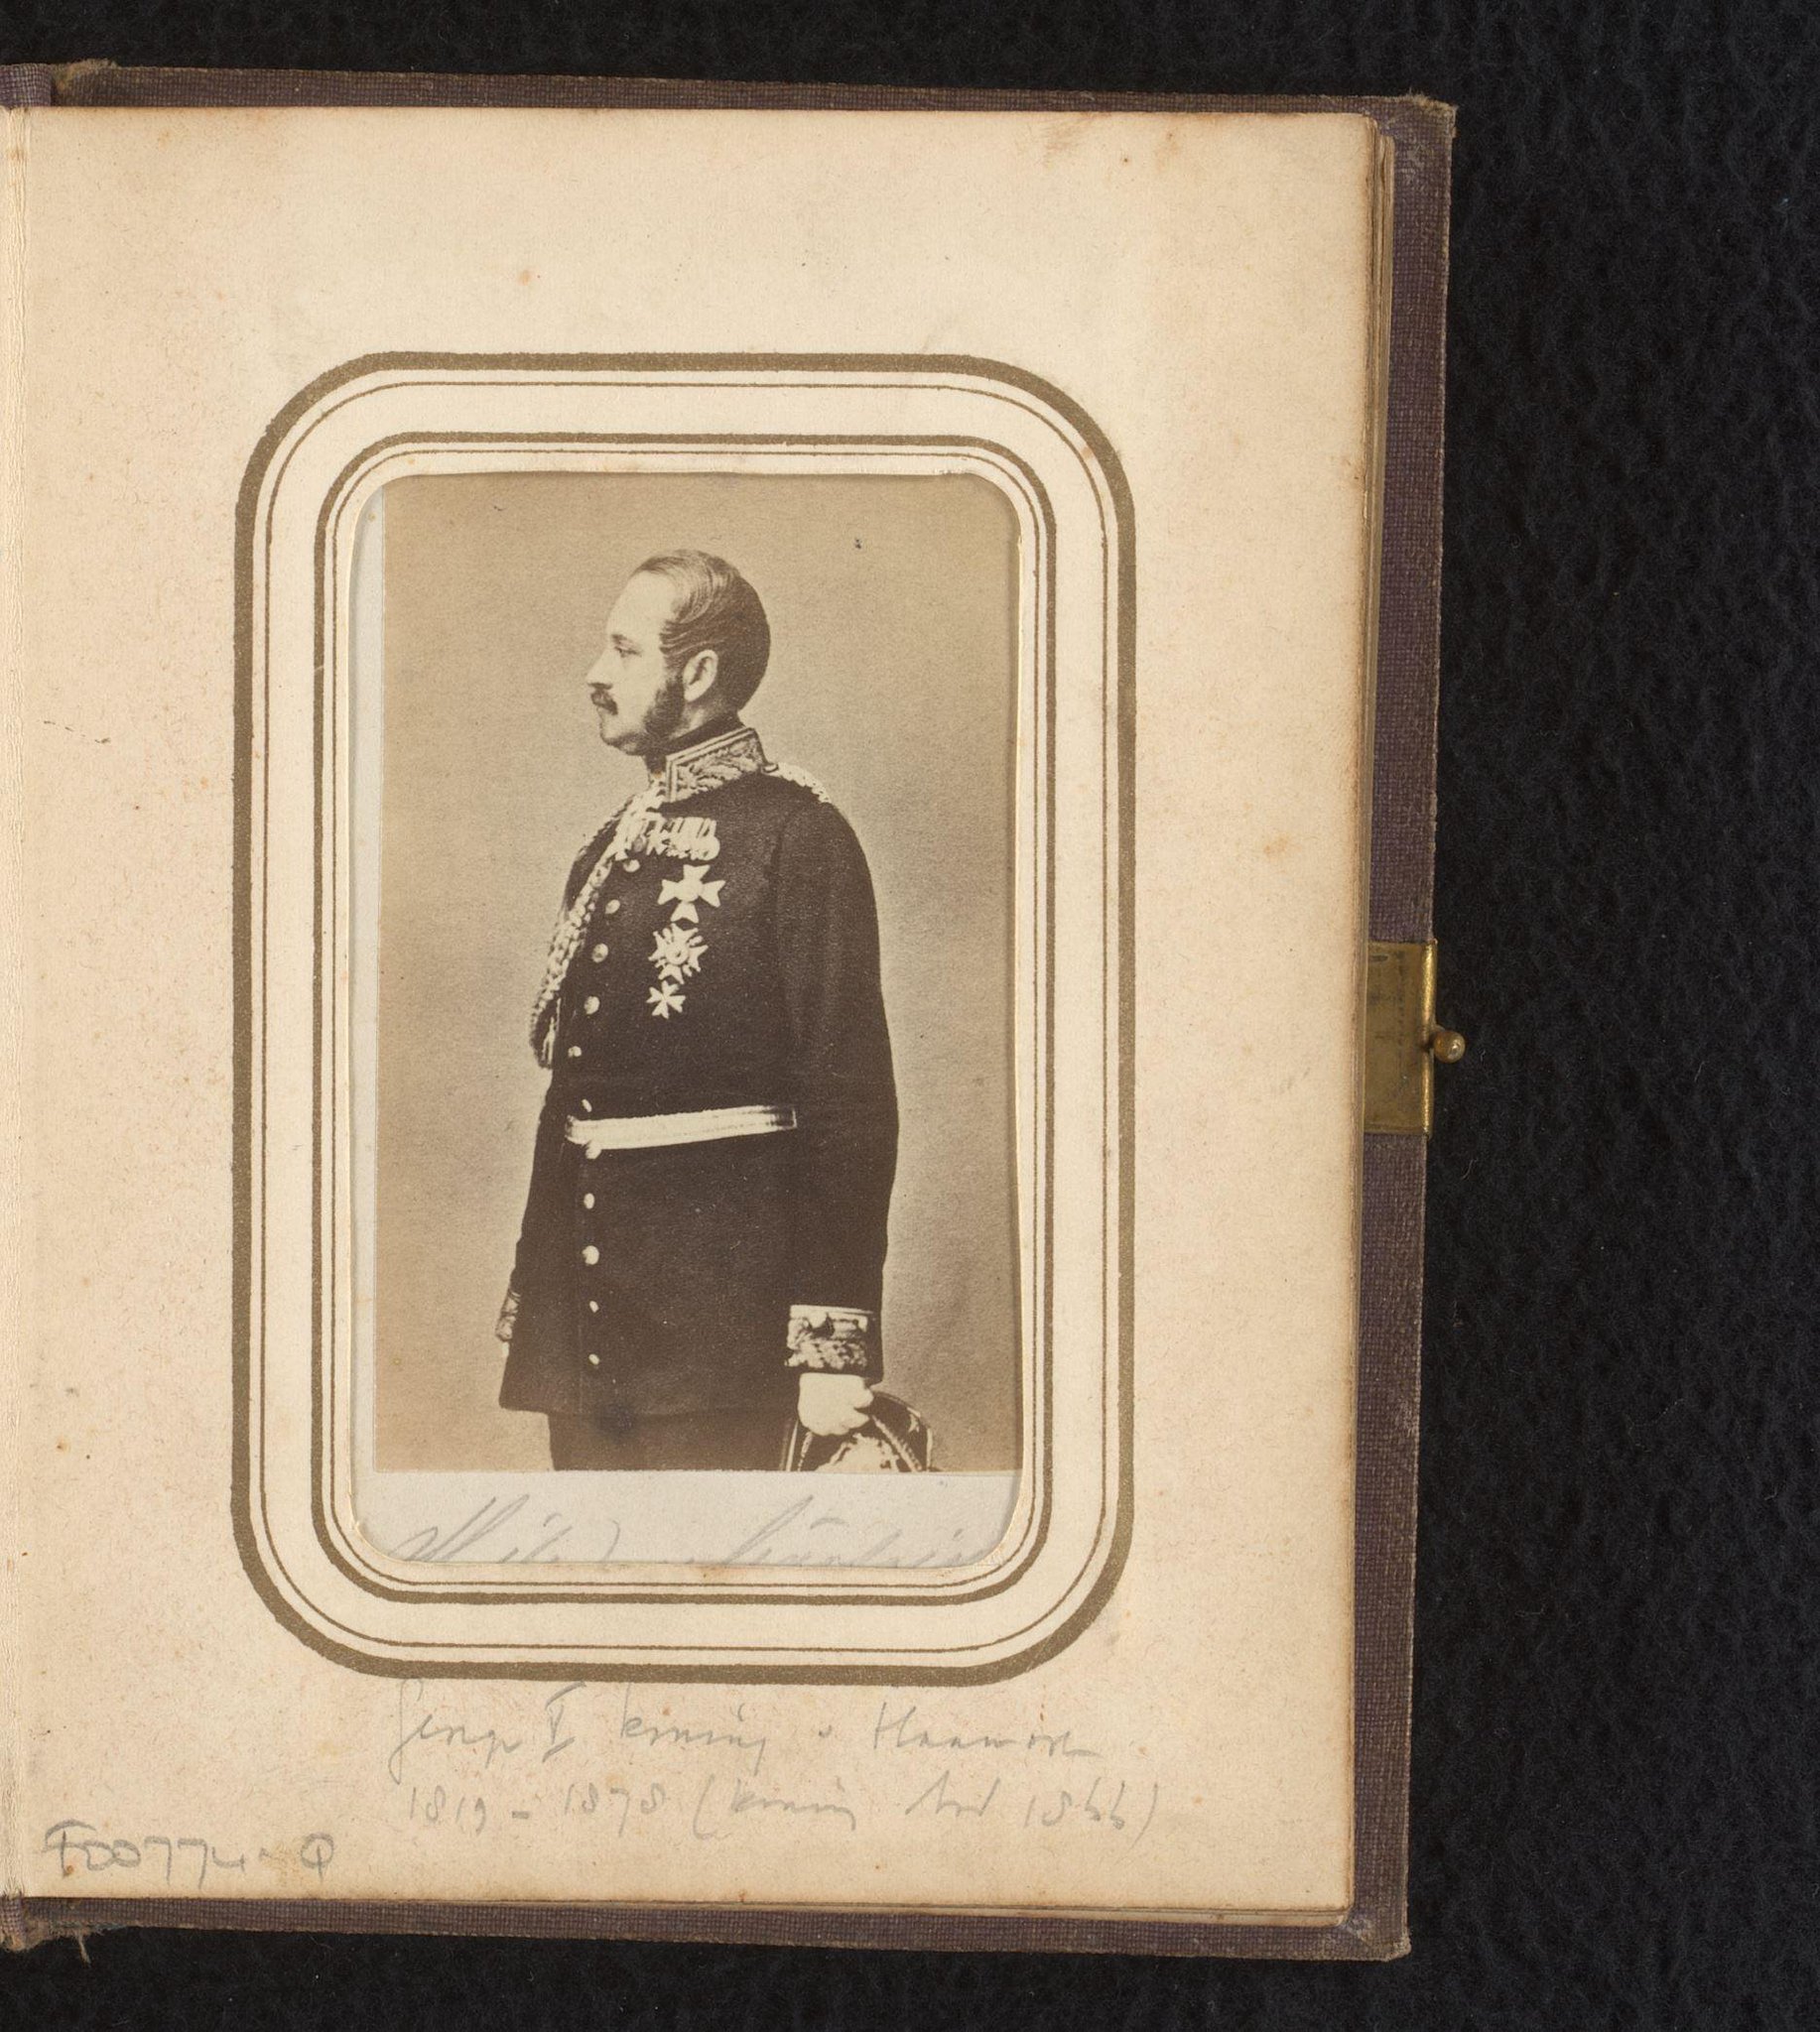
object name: album leaf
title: Portret van George V van Hannover in uniform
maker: Anonymous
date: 1850-1865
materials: cardboard, photographic support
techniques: albumen print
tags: historical persons, (military) uniforms, king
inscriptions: annotation: ‘George V koning v Hannover/ 1819-1898 (koning tot 1866)’, name: ‘H[...]er v Gar[..]en’